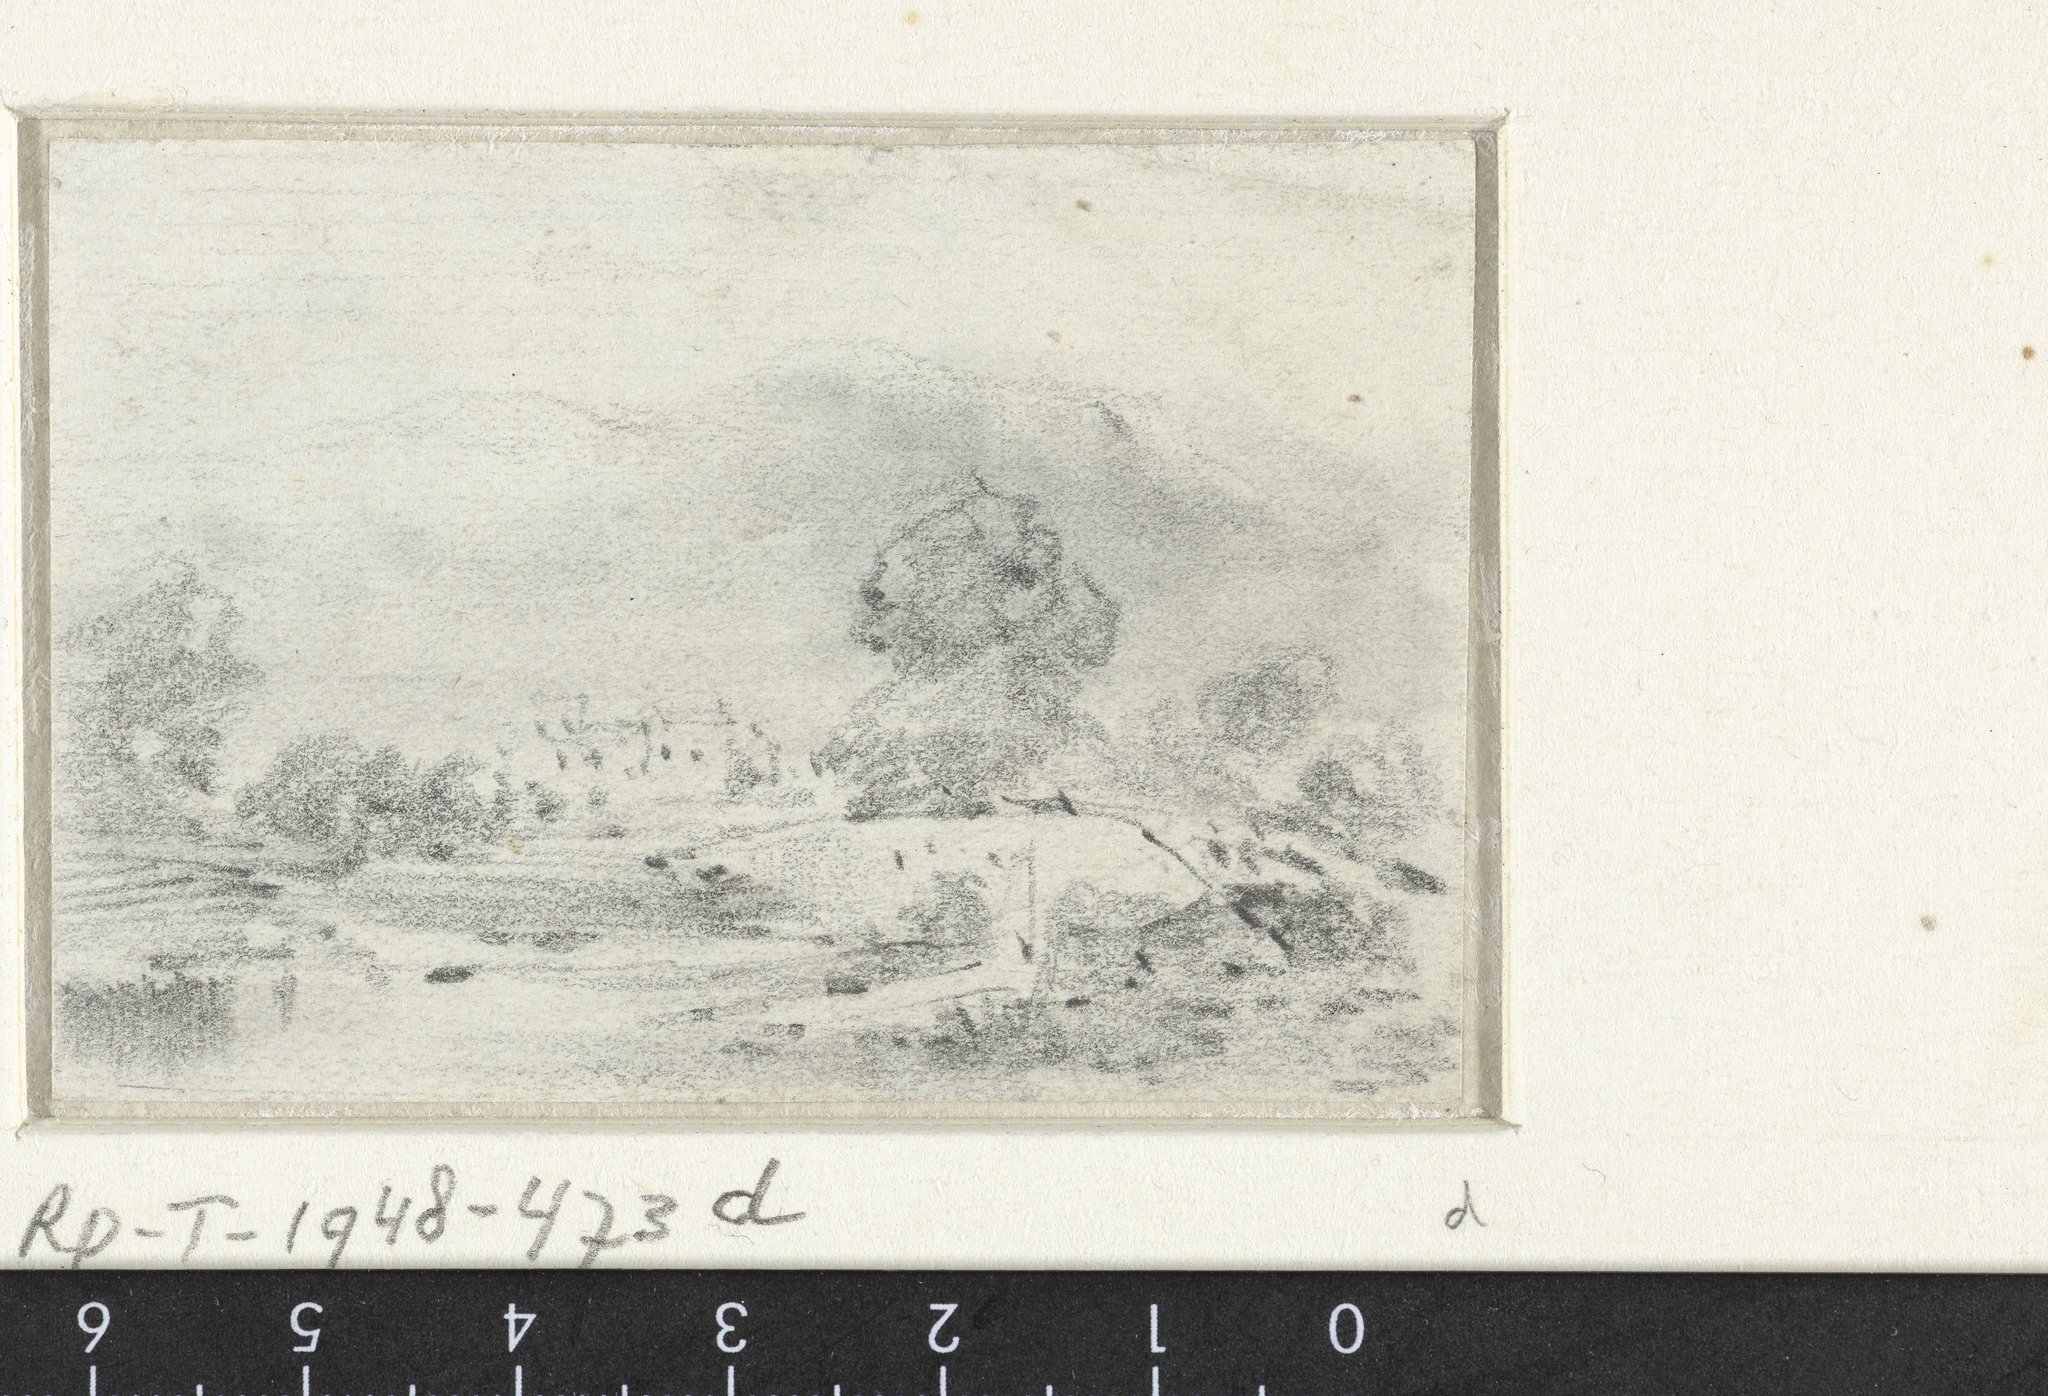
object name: drawing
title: Landschap met brug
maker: maxime françois antoine lalanne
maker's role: draughtsman, print maker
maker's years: 1827-1886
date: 1837-1886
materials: paper, pencil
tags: landscape with bridge, viaduct or aqueduct